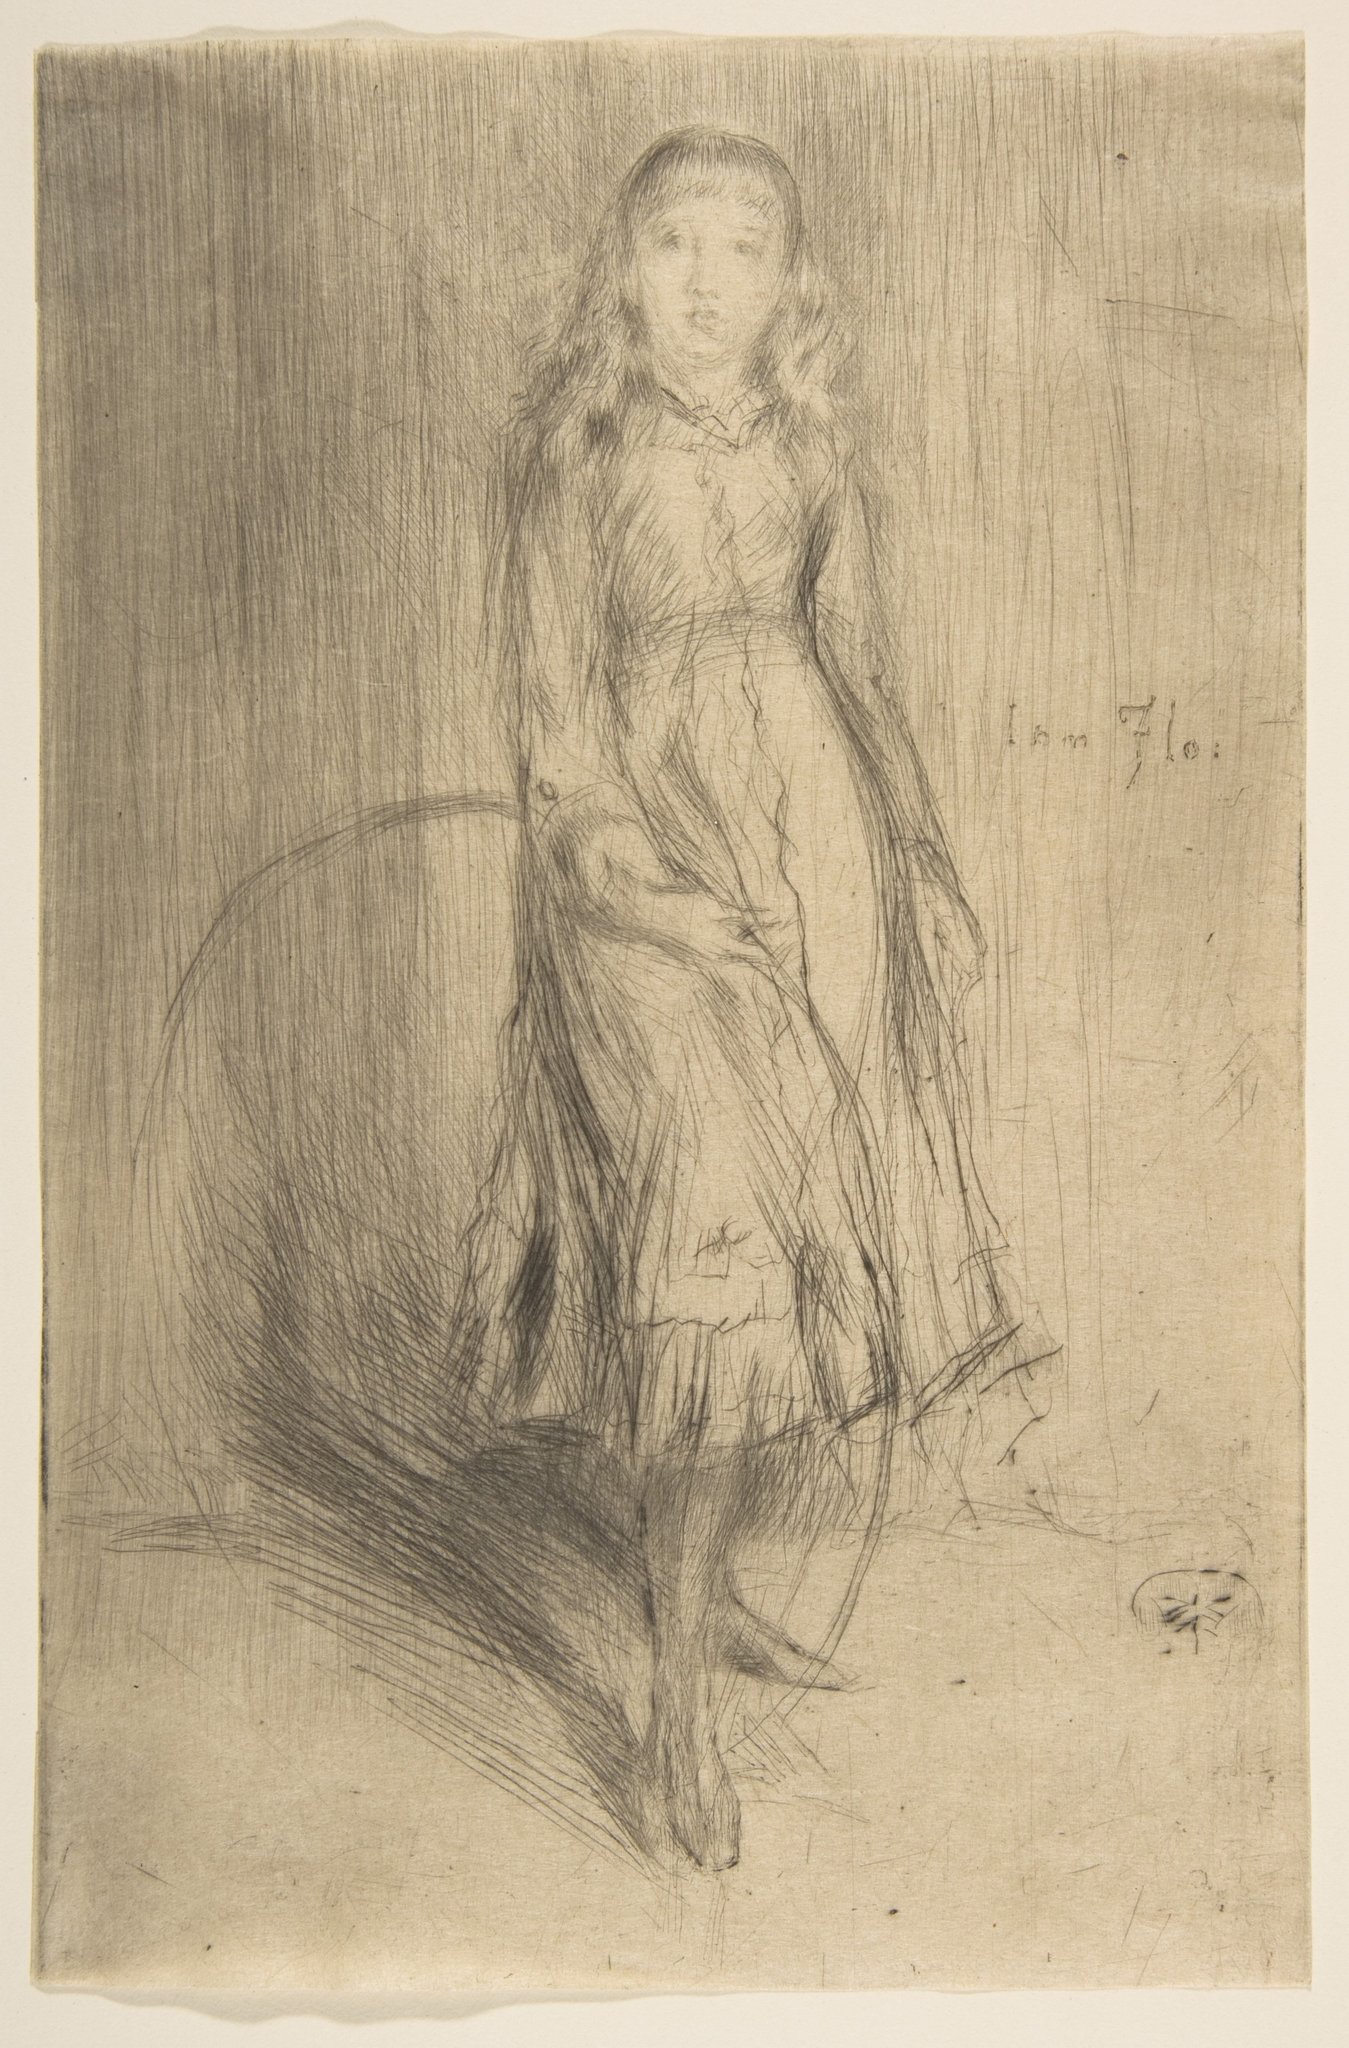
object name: print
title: Florence Leyland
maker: james mcneill whistler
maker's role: artist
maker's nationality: american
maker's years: 1834-1903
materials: ink, ivory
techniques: drypoint, printing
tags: girls